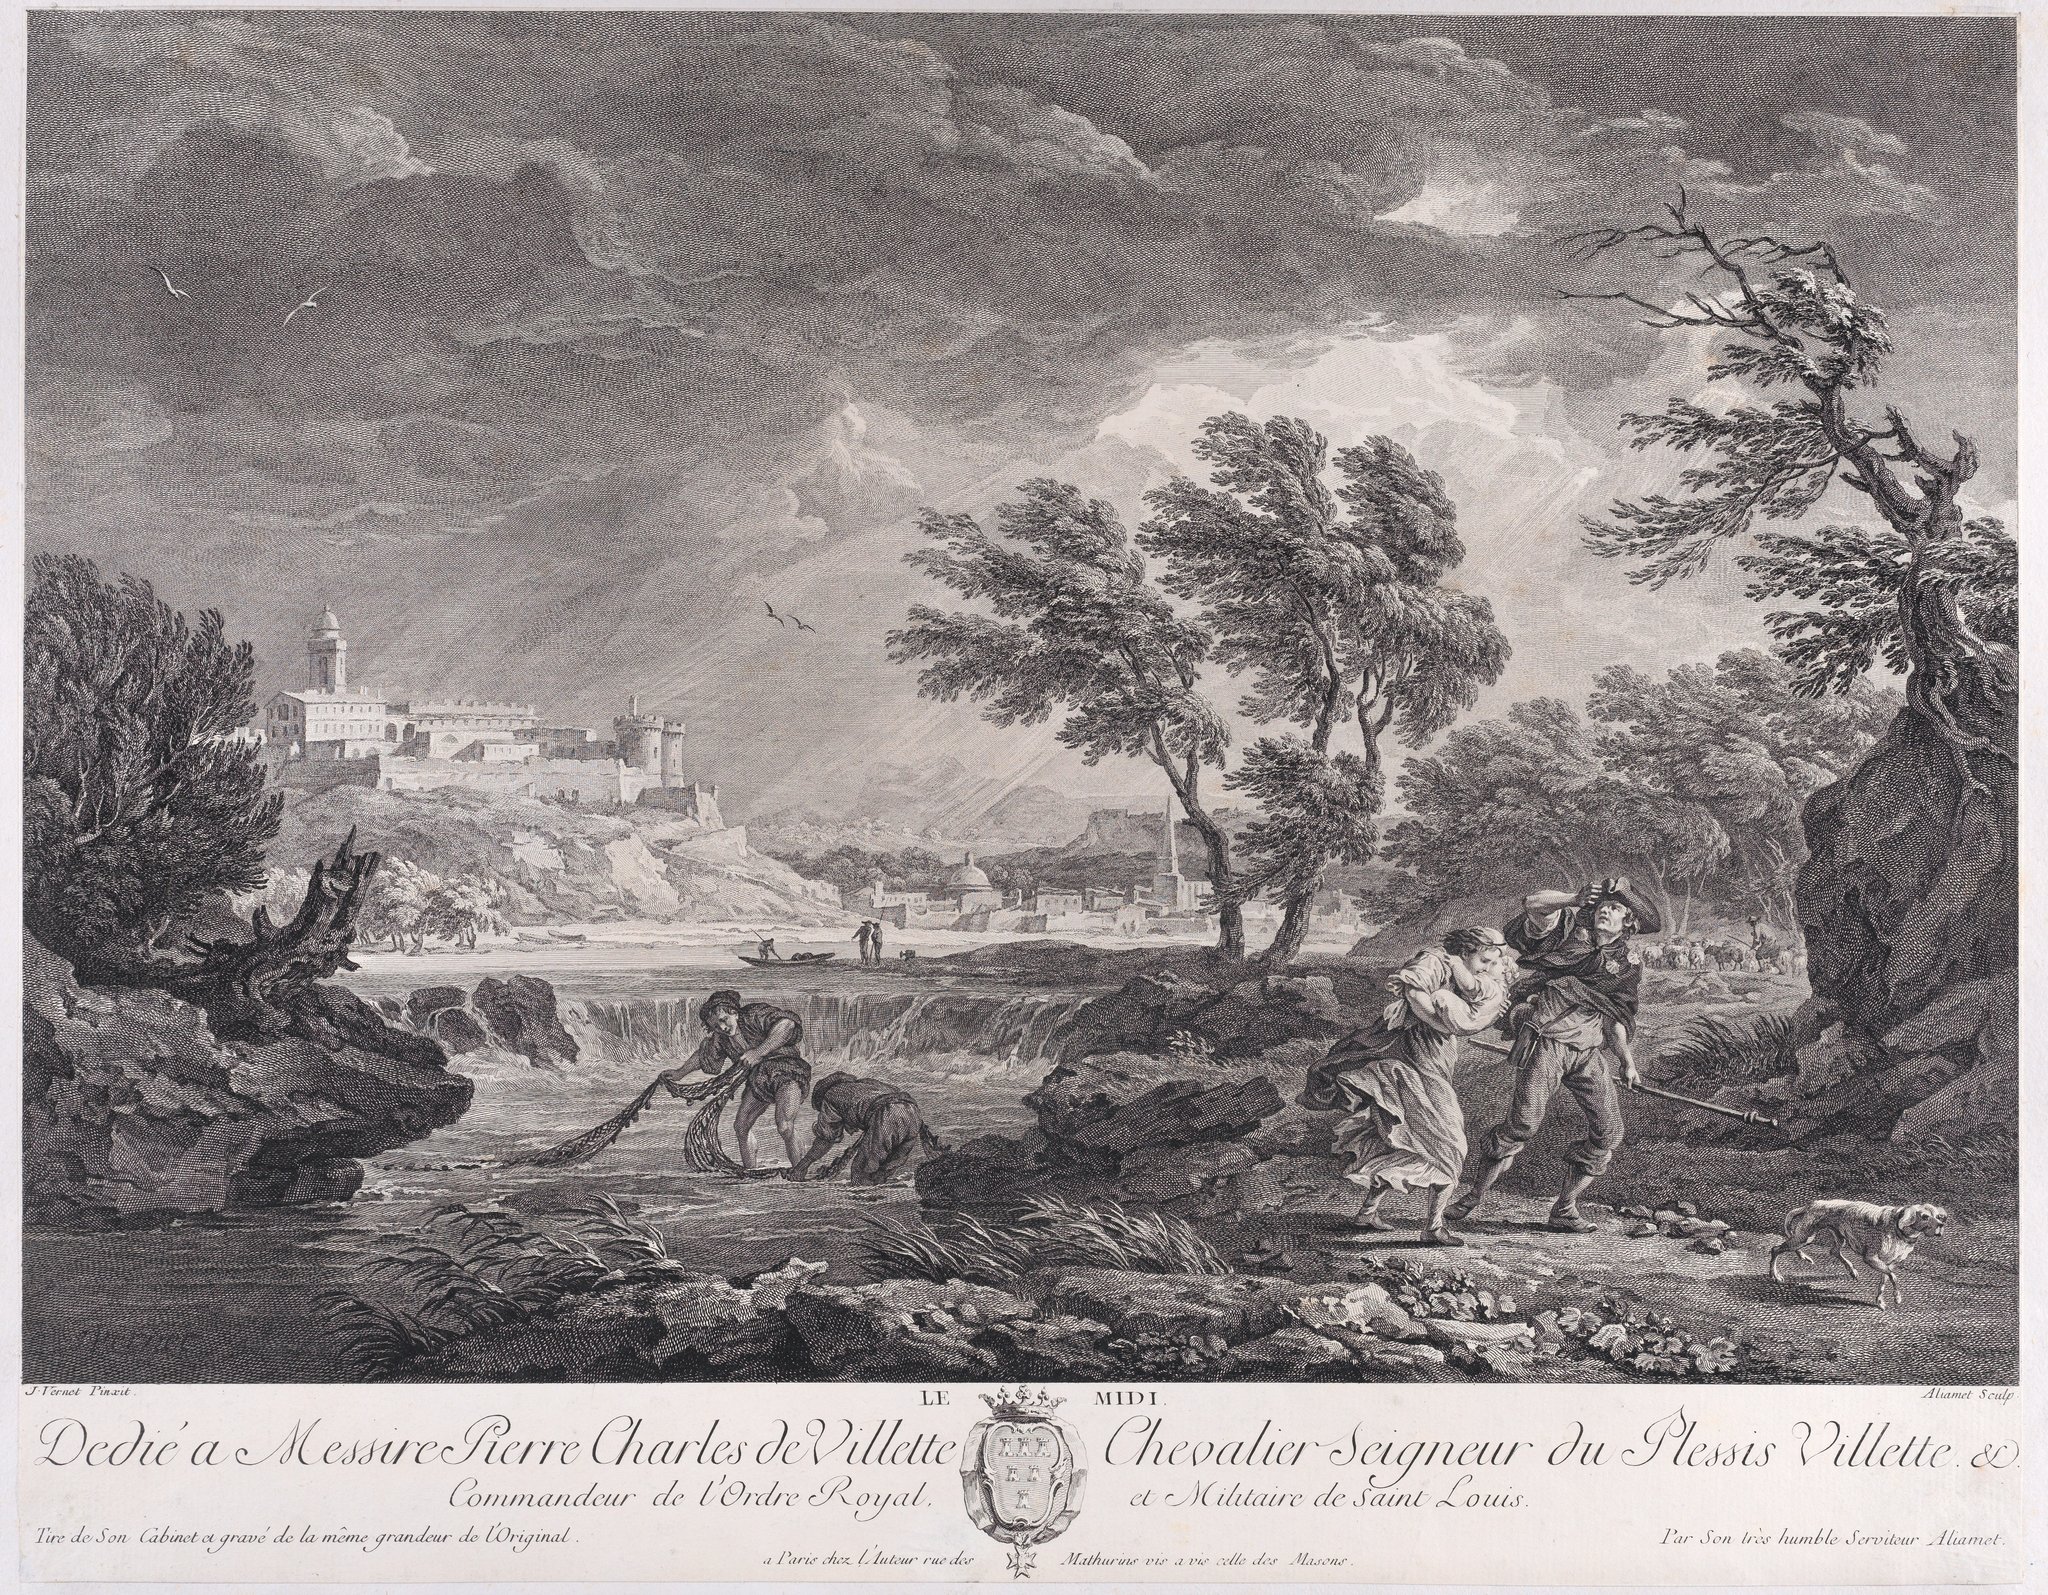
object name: print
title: Noon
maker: joseph vernet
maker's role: artist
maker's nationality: french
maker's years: 1714-1789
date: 1770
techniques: engraving